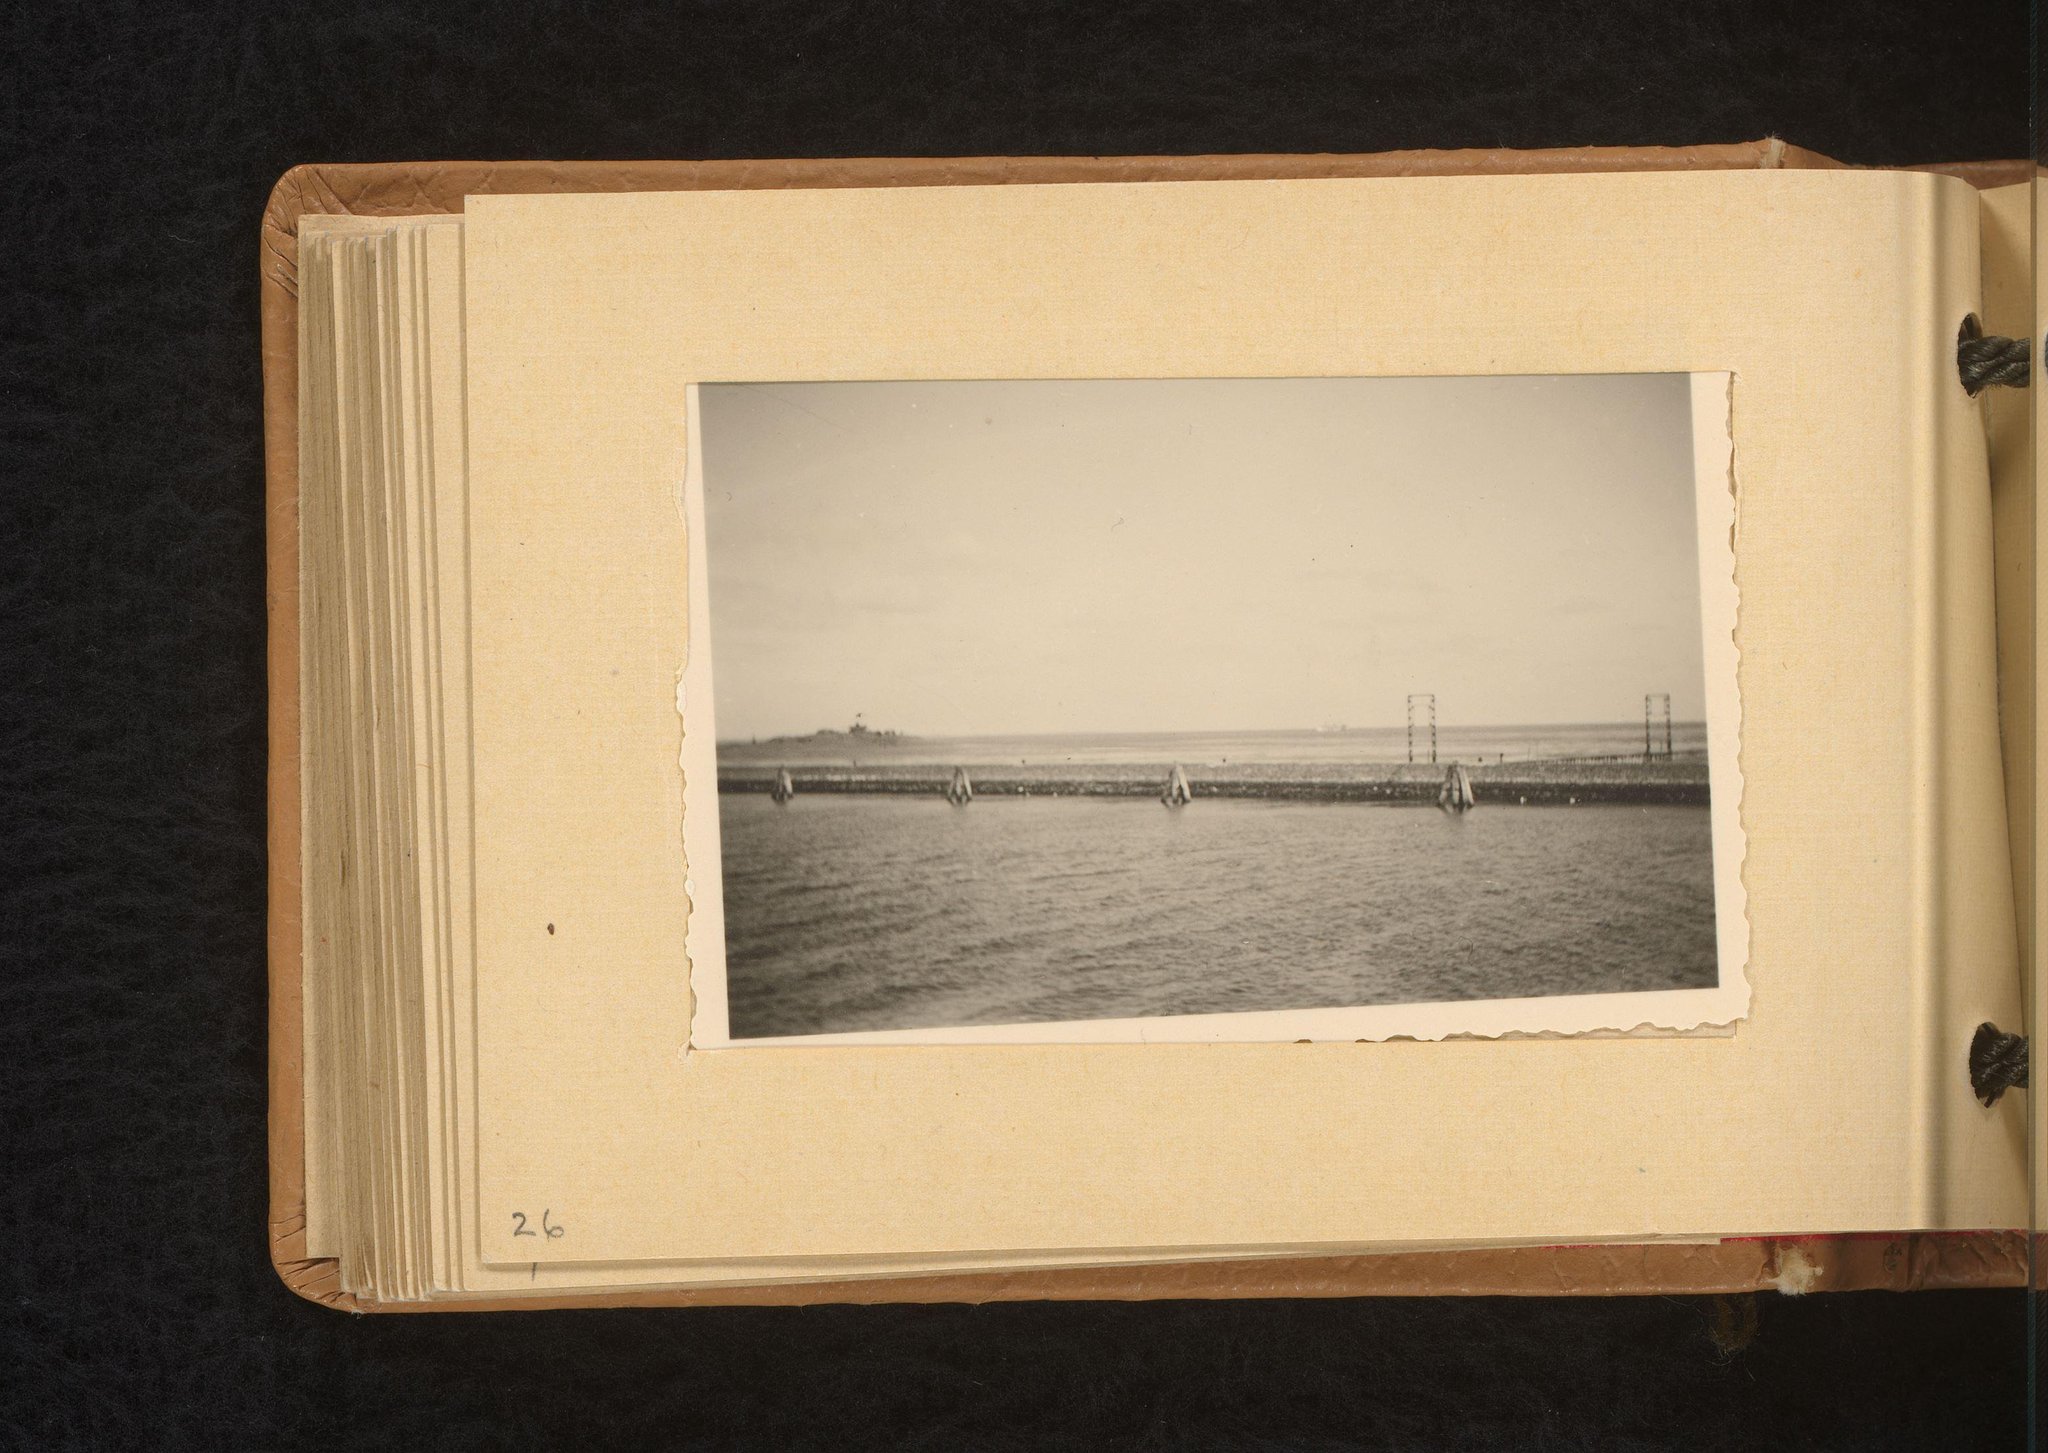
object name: photograph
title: Dijk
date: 1940-1943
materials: paper, photographic support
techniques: gelatin silver print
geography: den helder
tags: dikes, levee, occupation ~ war, netherlands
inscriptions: name: ‘Keizerstr. 113’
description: Albumblad met een foto vanaf het water van een dijk, mogelijk bij de Afsluitdijk. Onderdeel van een klein album van de Kriegsmarine in Nederland.